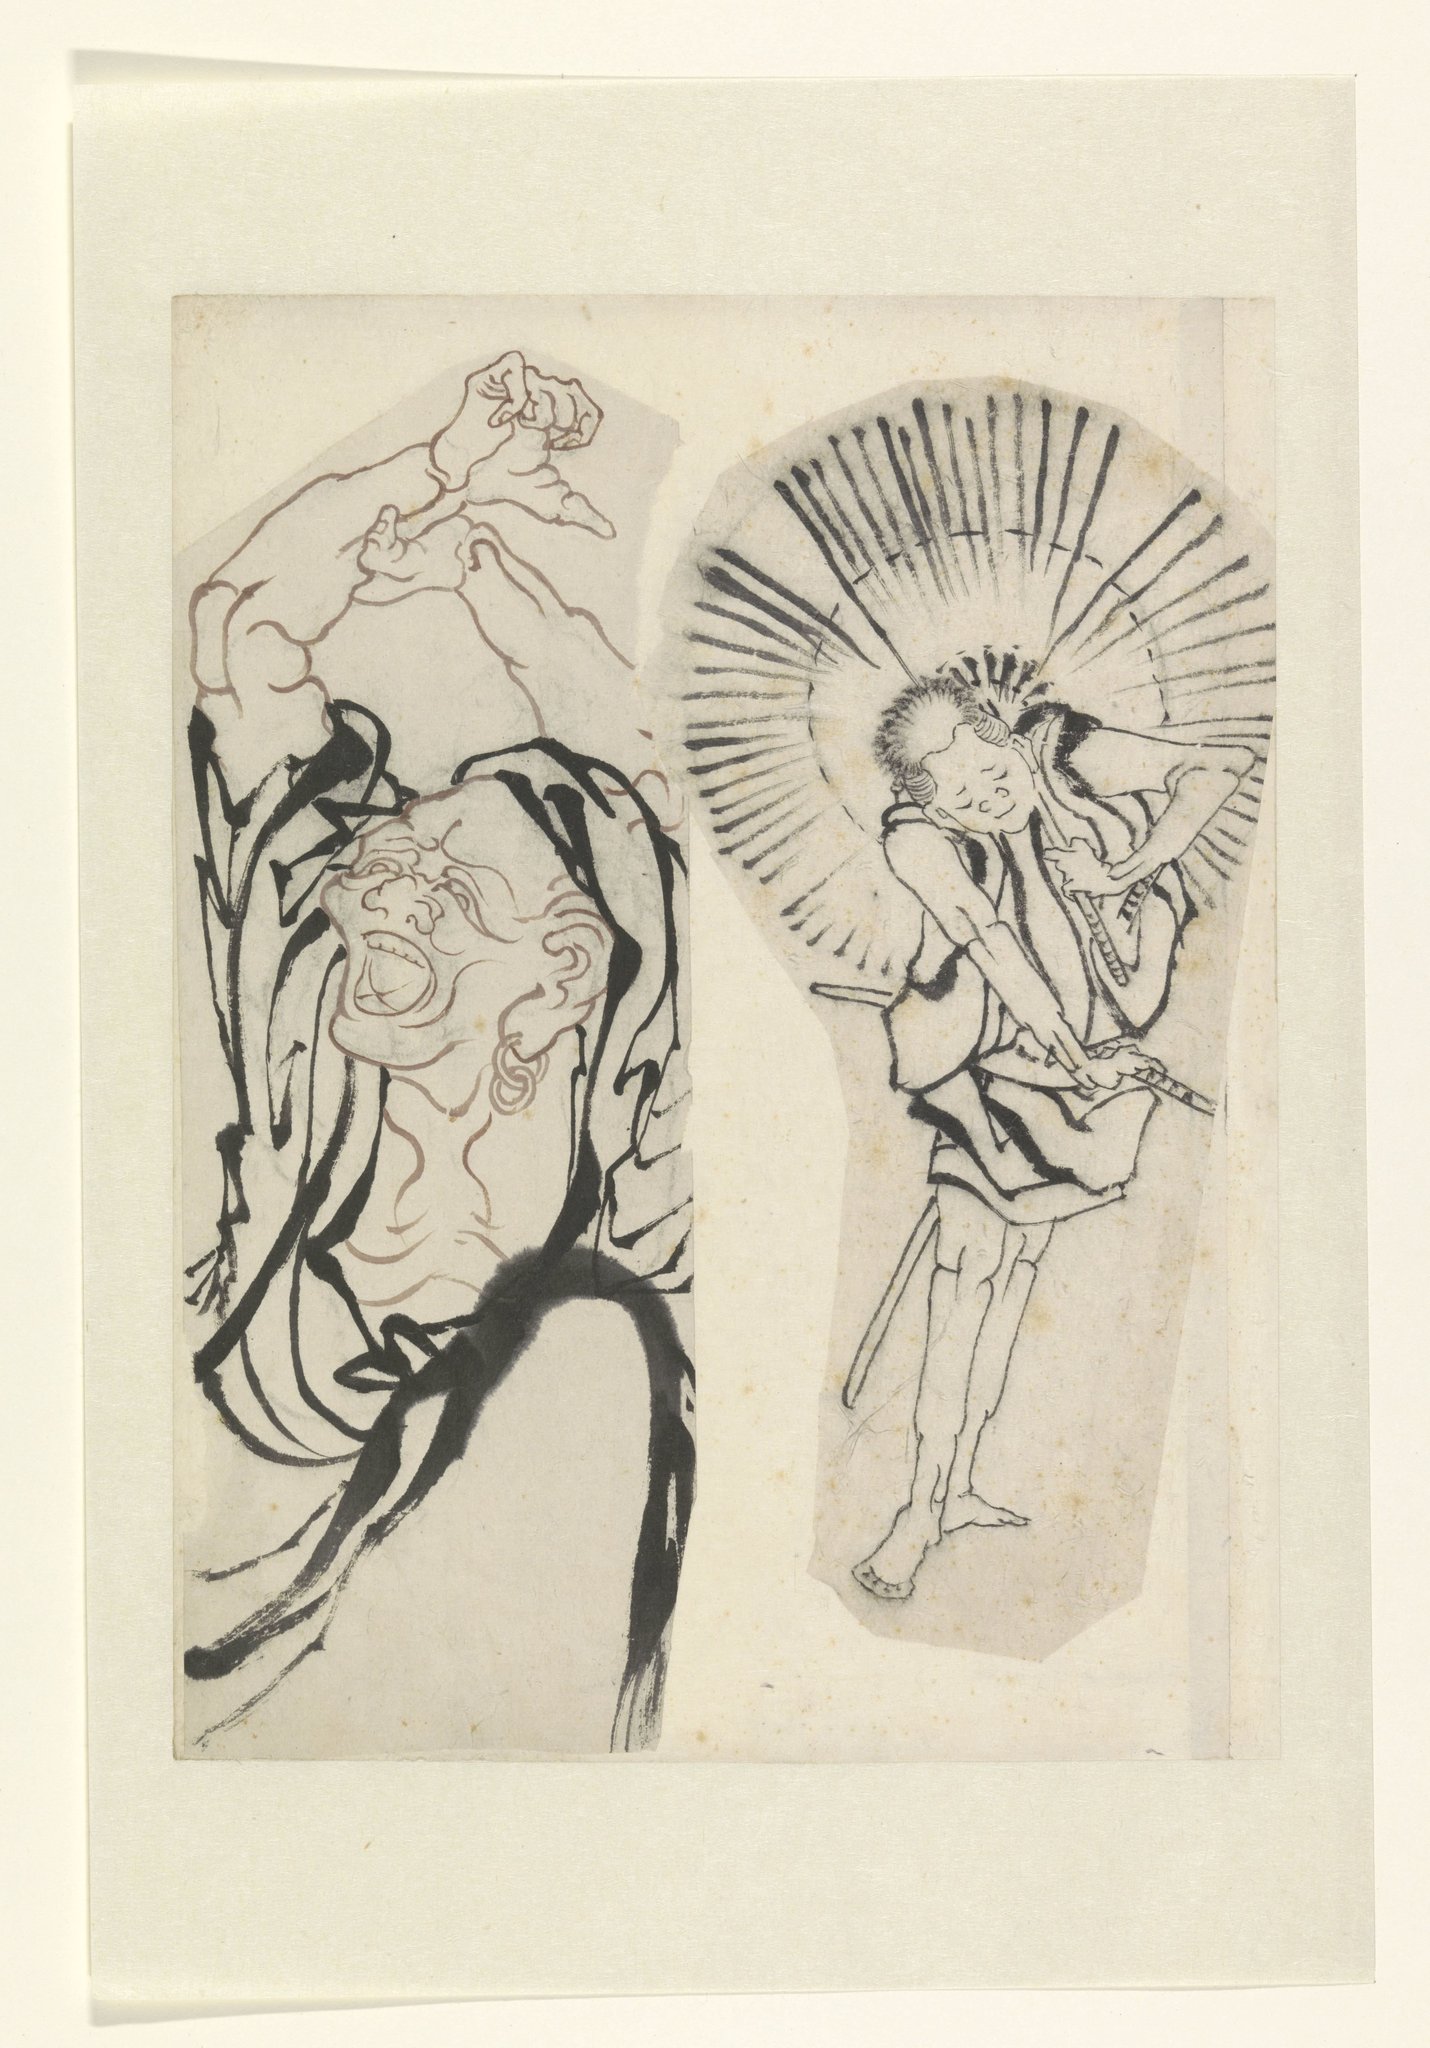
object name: drawing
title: Twee figuren waarvan de rechter een parasol en een zwaard in de hand heeft (Hayano Kampei?)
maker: Anonymous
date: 1800-1900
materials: charcoal, paper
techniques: brush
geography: japan